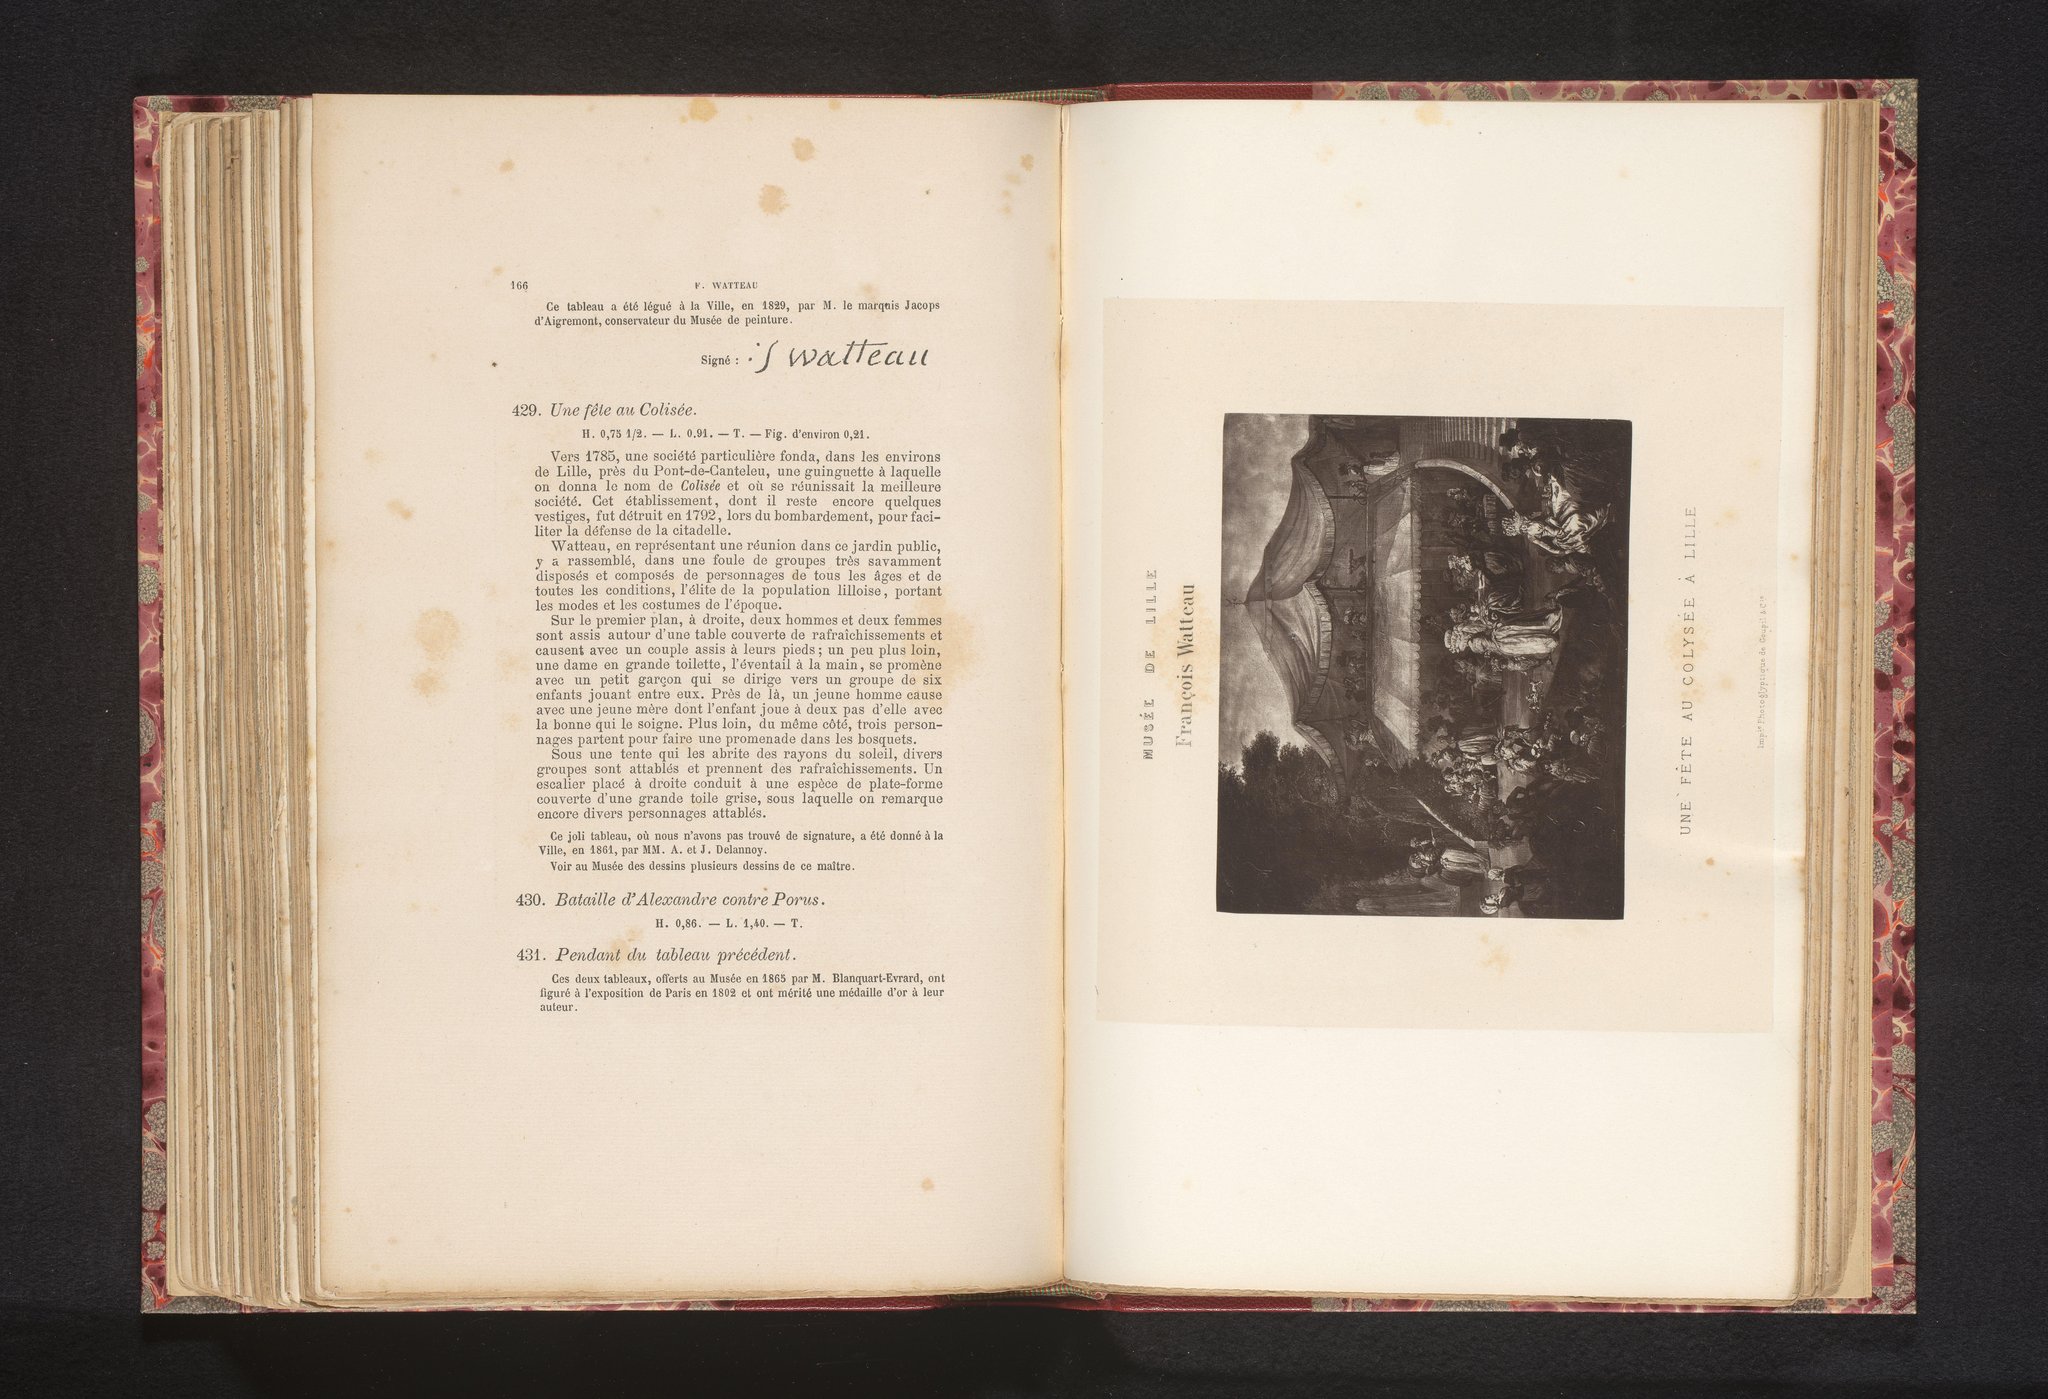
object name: photomechanical print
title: Fotoreproductie van een schilderij door François-Louis-Joseph Watteau, voorstellend een feest in Lille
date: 1862-1872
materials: paper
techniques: woodburytype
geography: lille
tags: festivities, lille